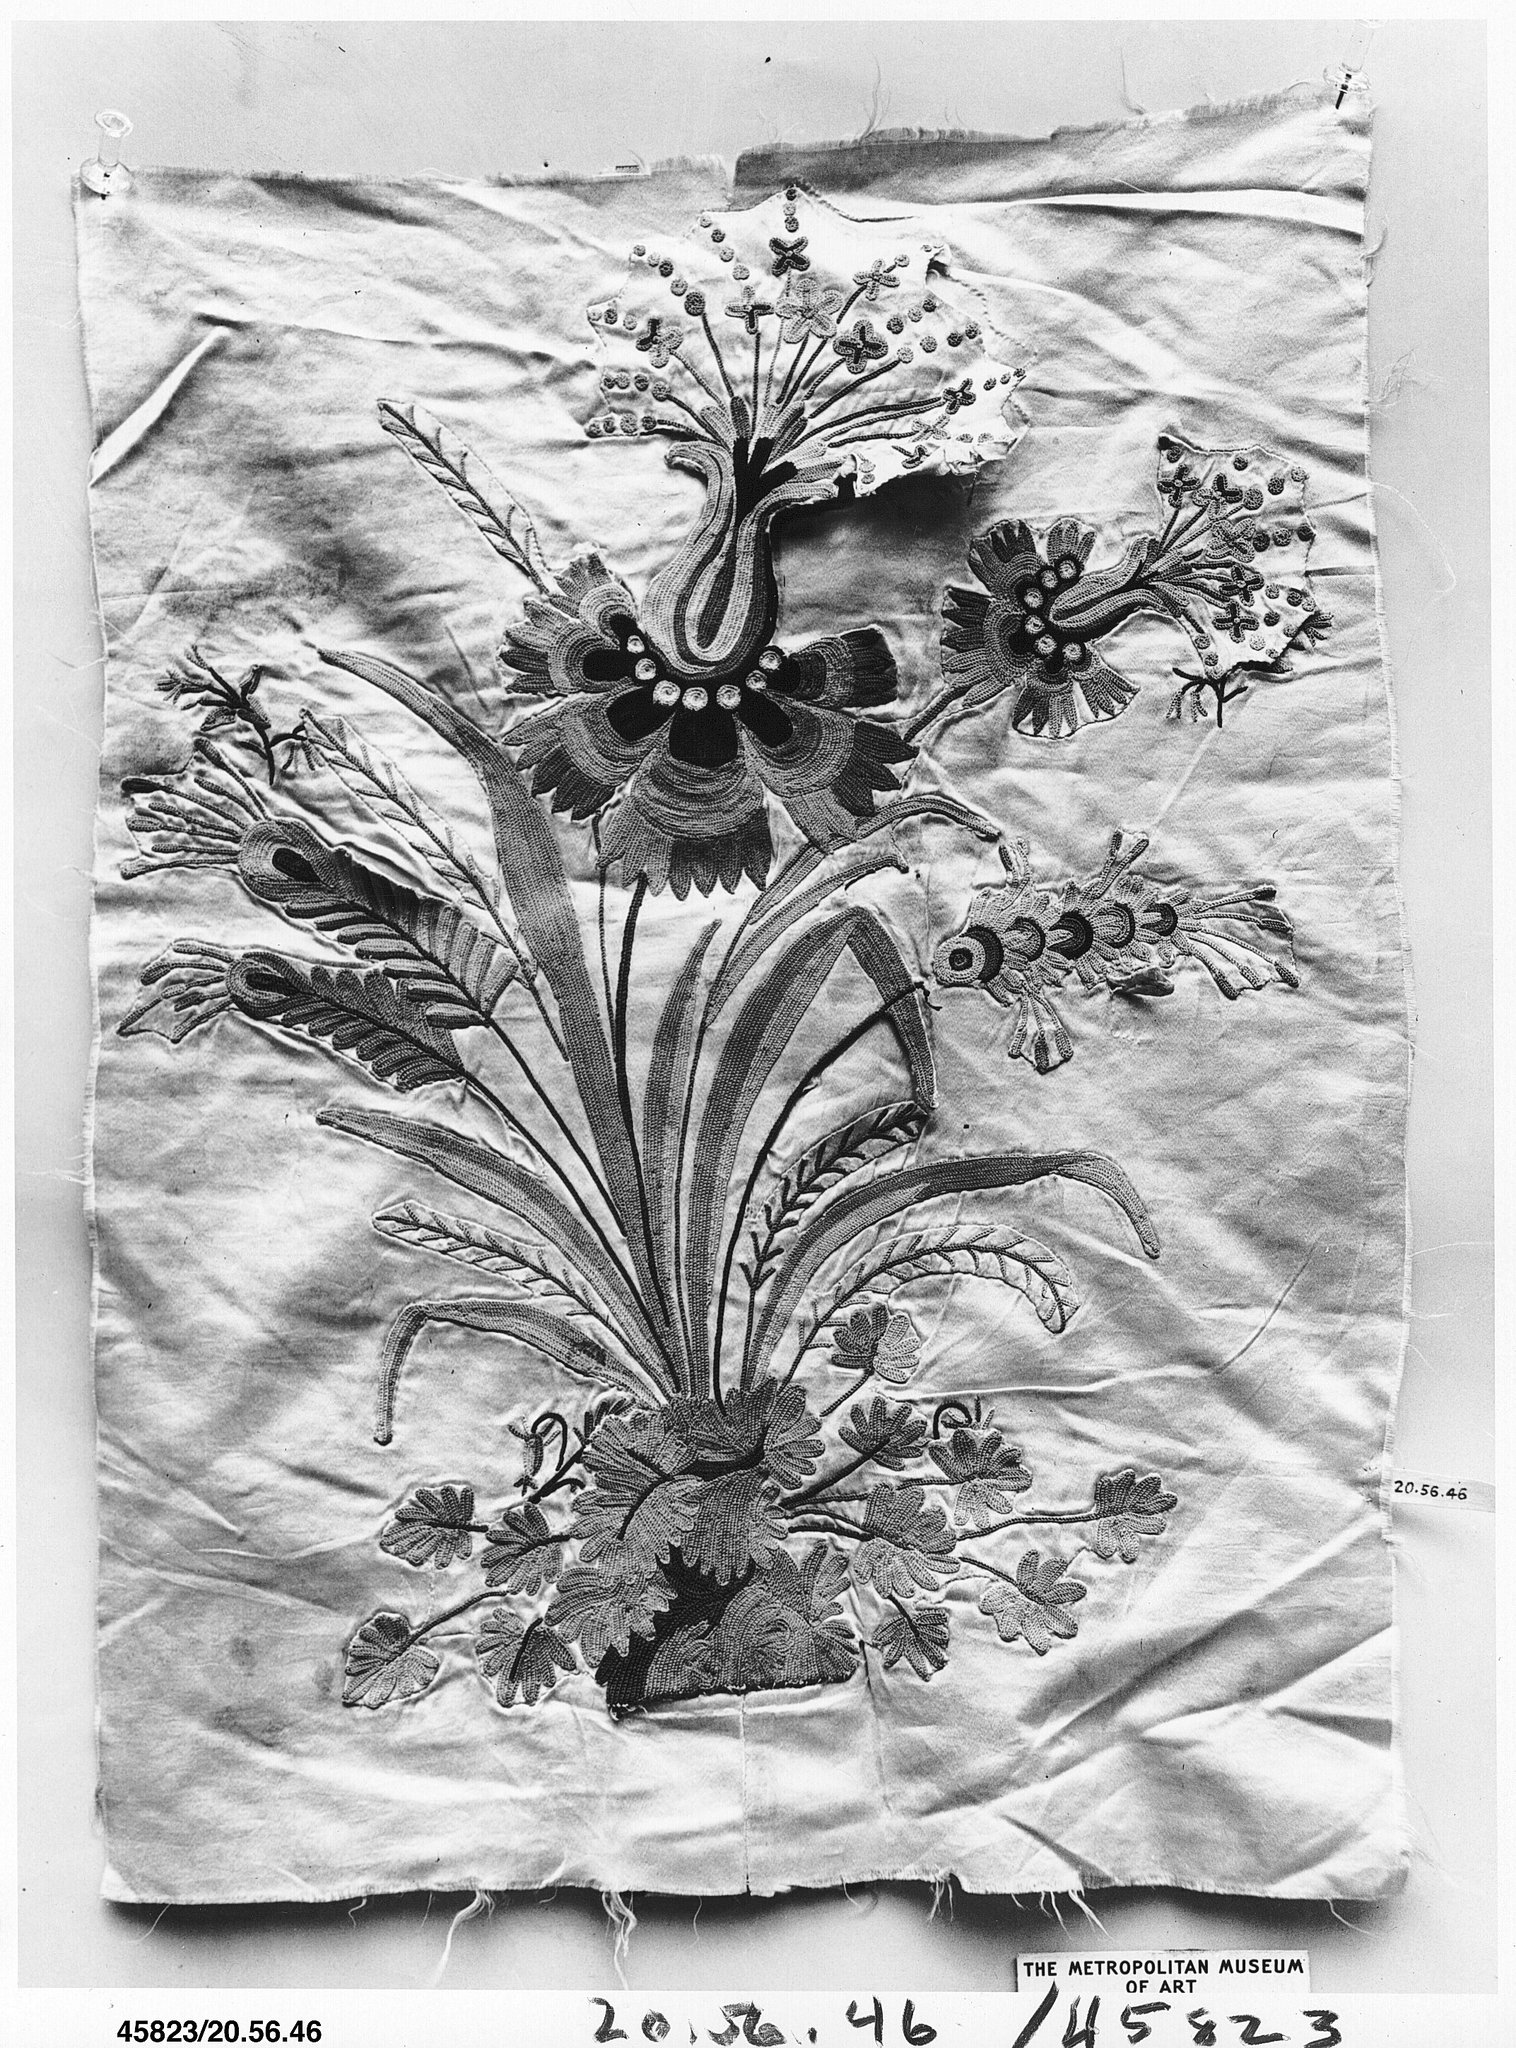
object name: embroidery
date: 1774-1792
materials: silk